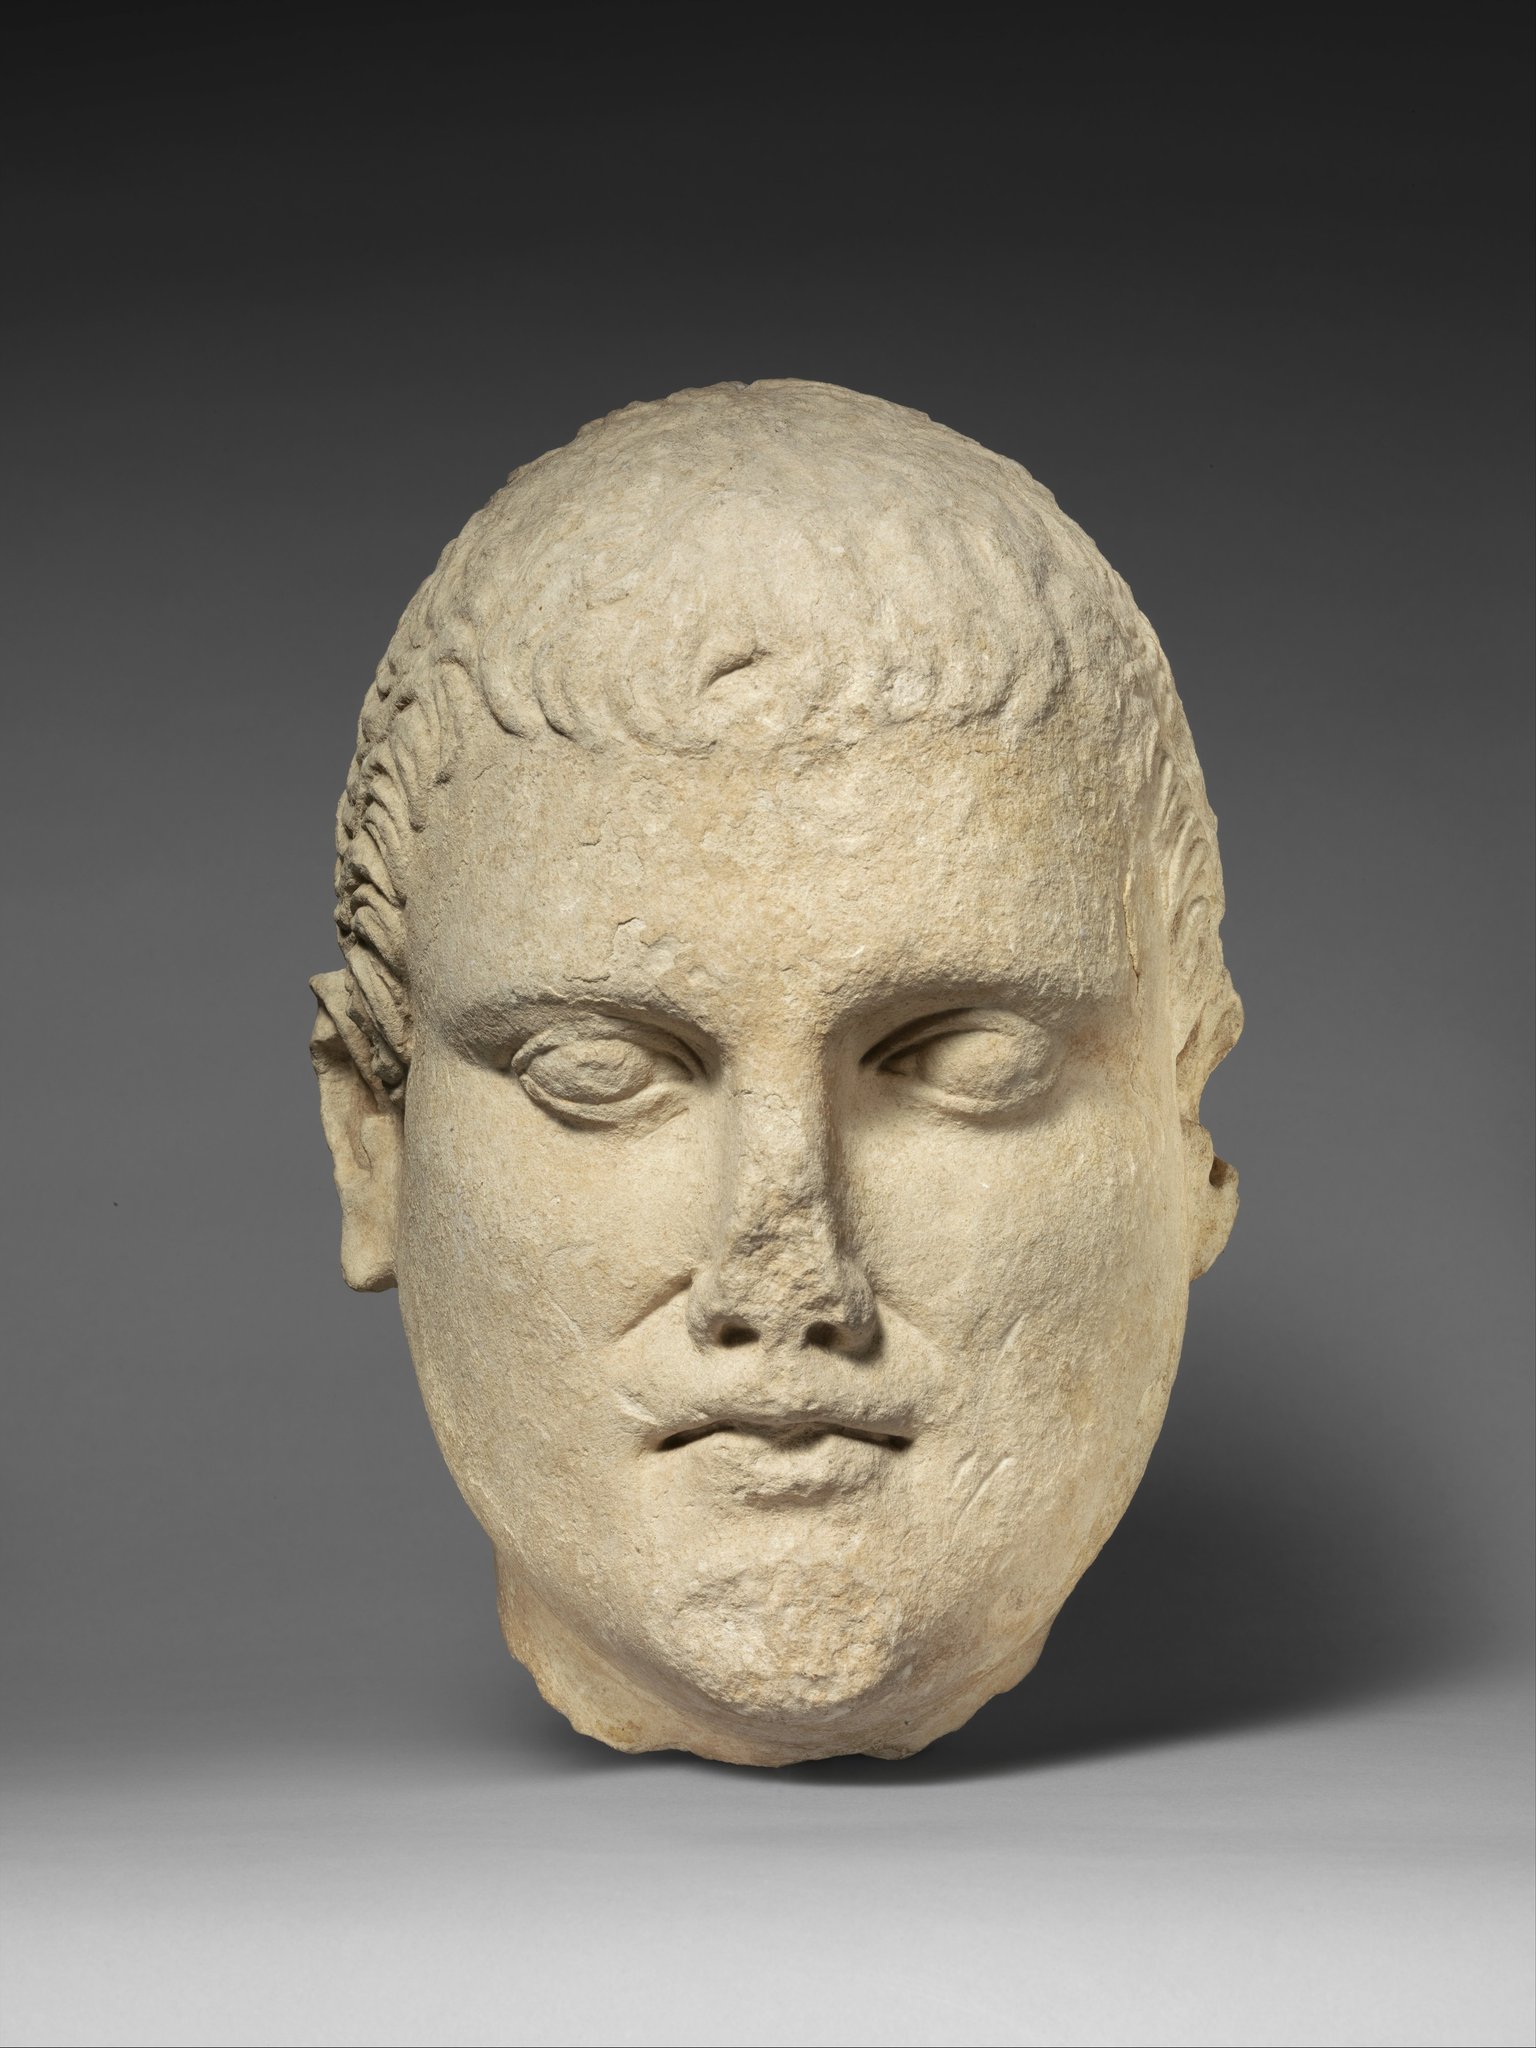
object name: head of a man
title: Limestone head of beardless male votary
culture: cypriot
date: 100-68 BCE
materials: limestone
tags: heads,men